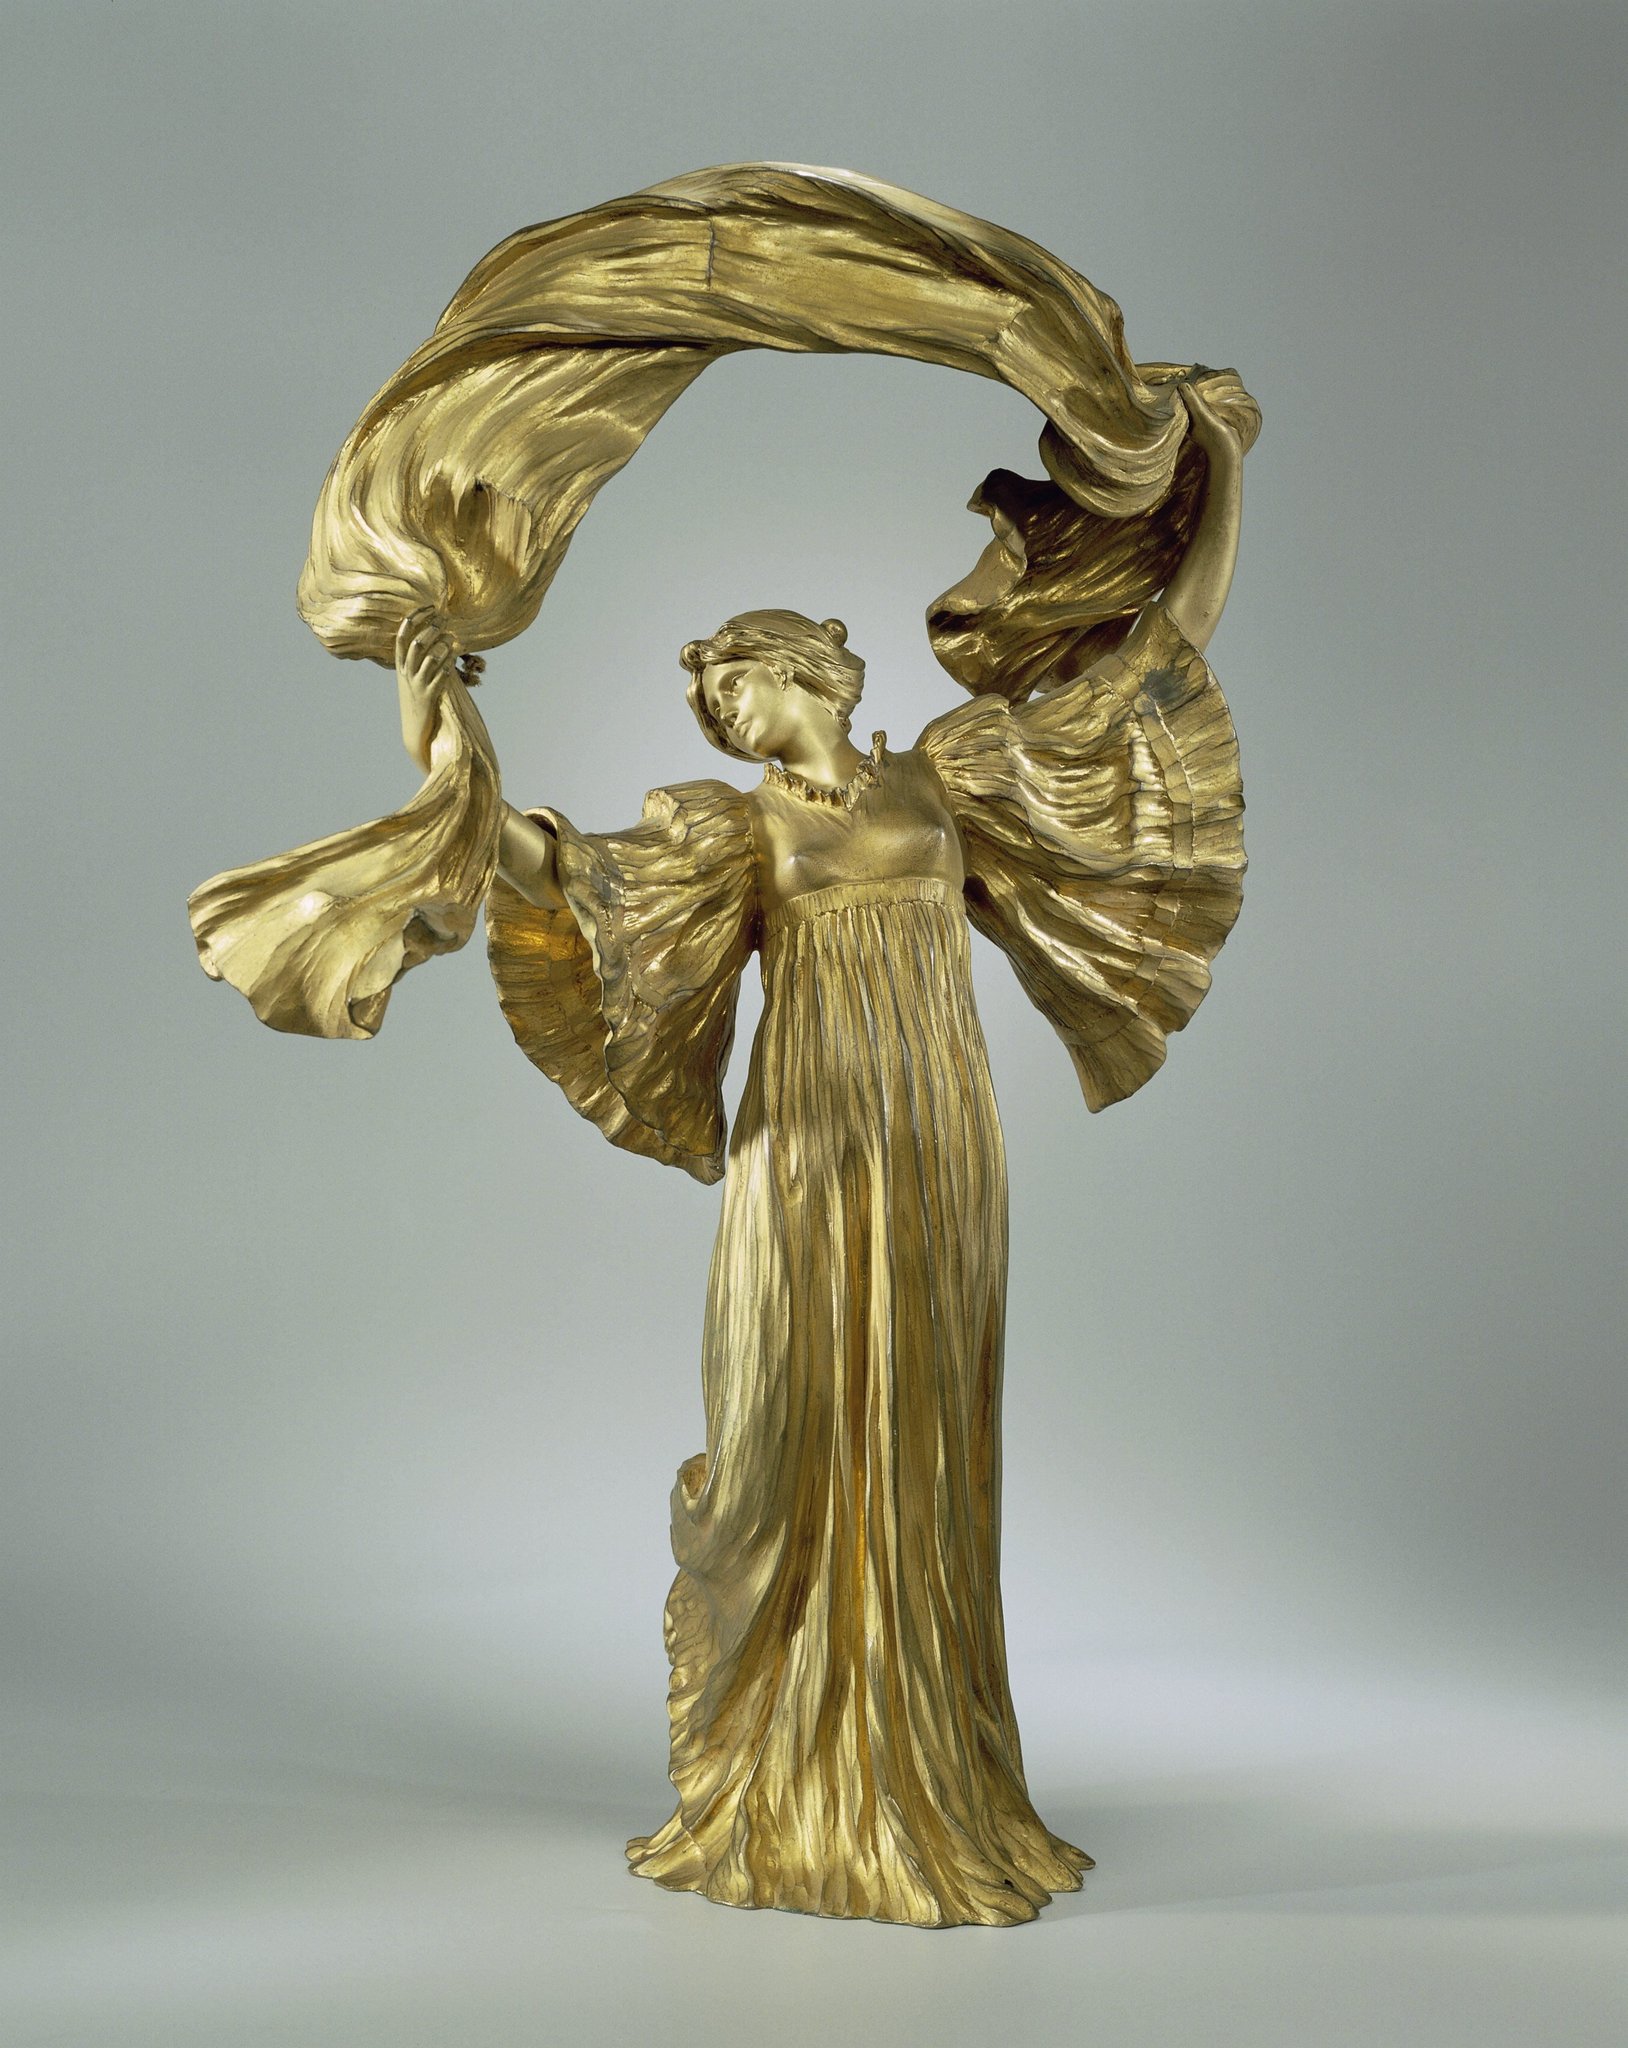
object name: sculpture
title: Dancer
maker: agathon leonard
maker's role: sculptor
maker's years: 1841-1923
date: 1900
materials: bronze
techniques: gilding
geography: paris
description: The pioneering American dancer Loïe Fuller was the muse of many artists in fin-de-siècle Paris. This bronze depicts Fuller performing the expressive modern dance Le jeu de l’écharpe (The scarf game). The scarf swirling over her head contains a fitting so that the bronze can be used as a lamp.